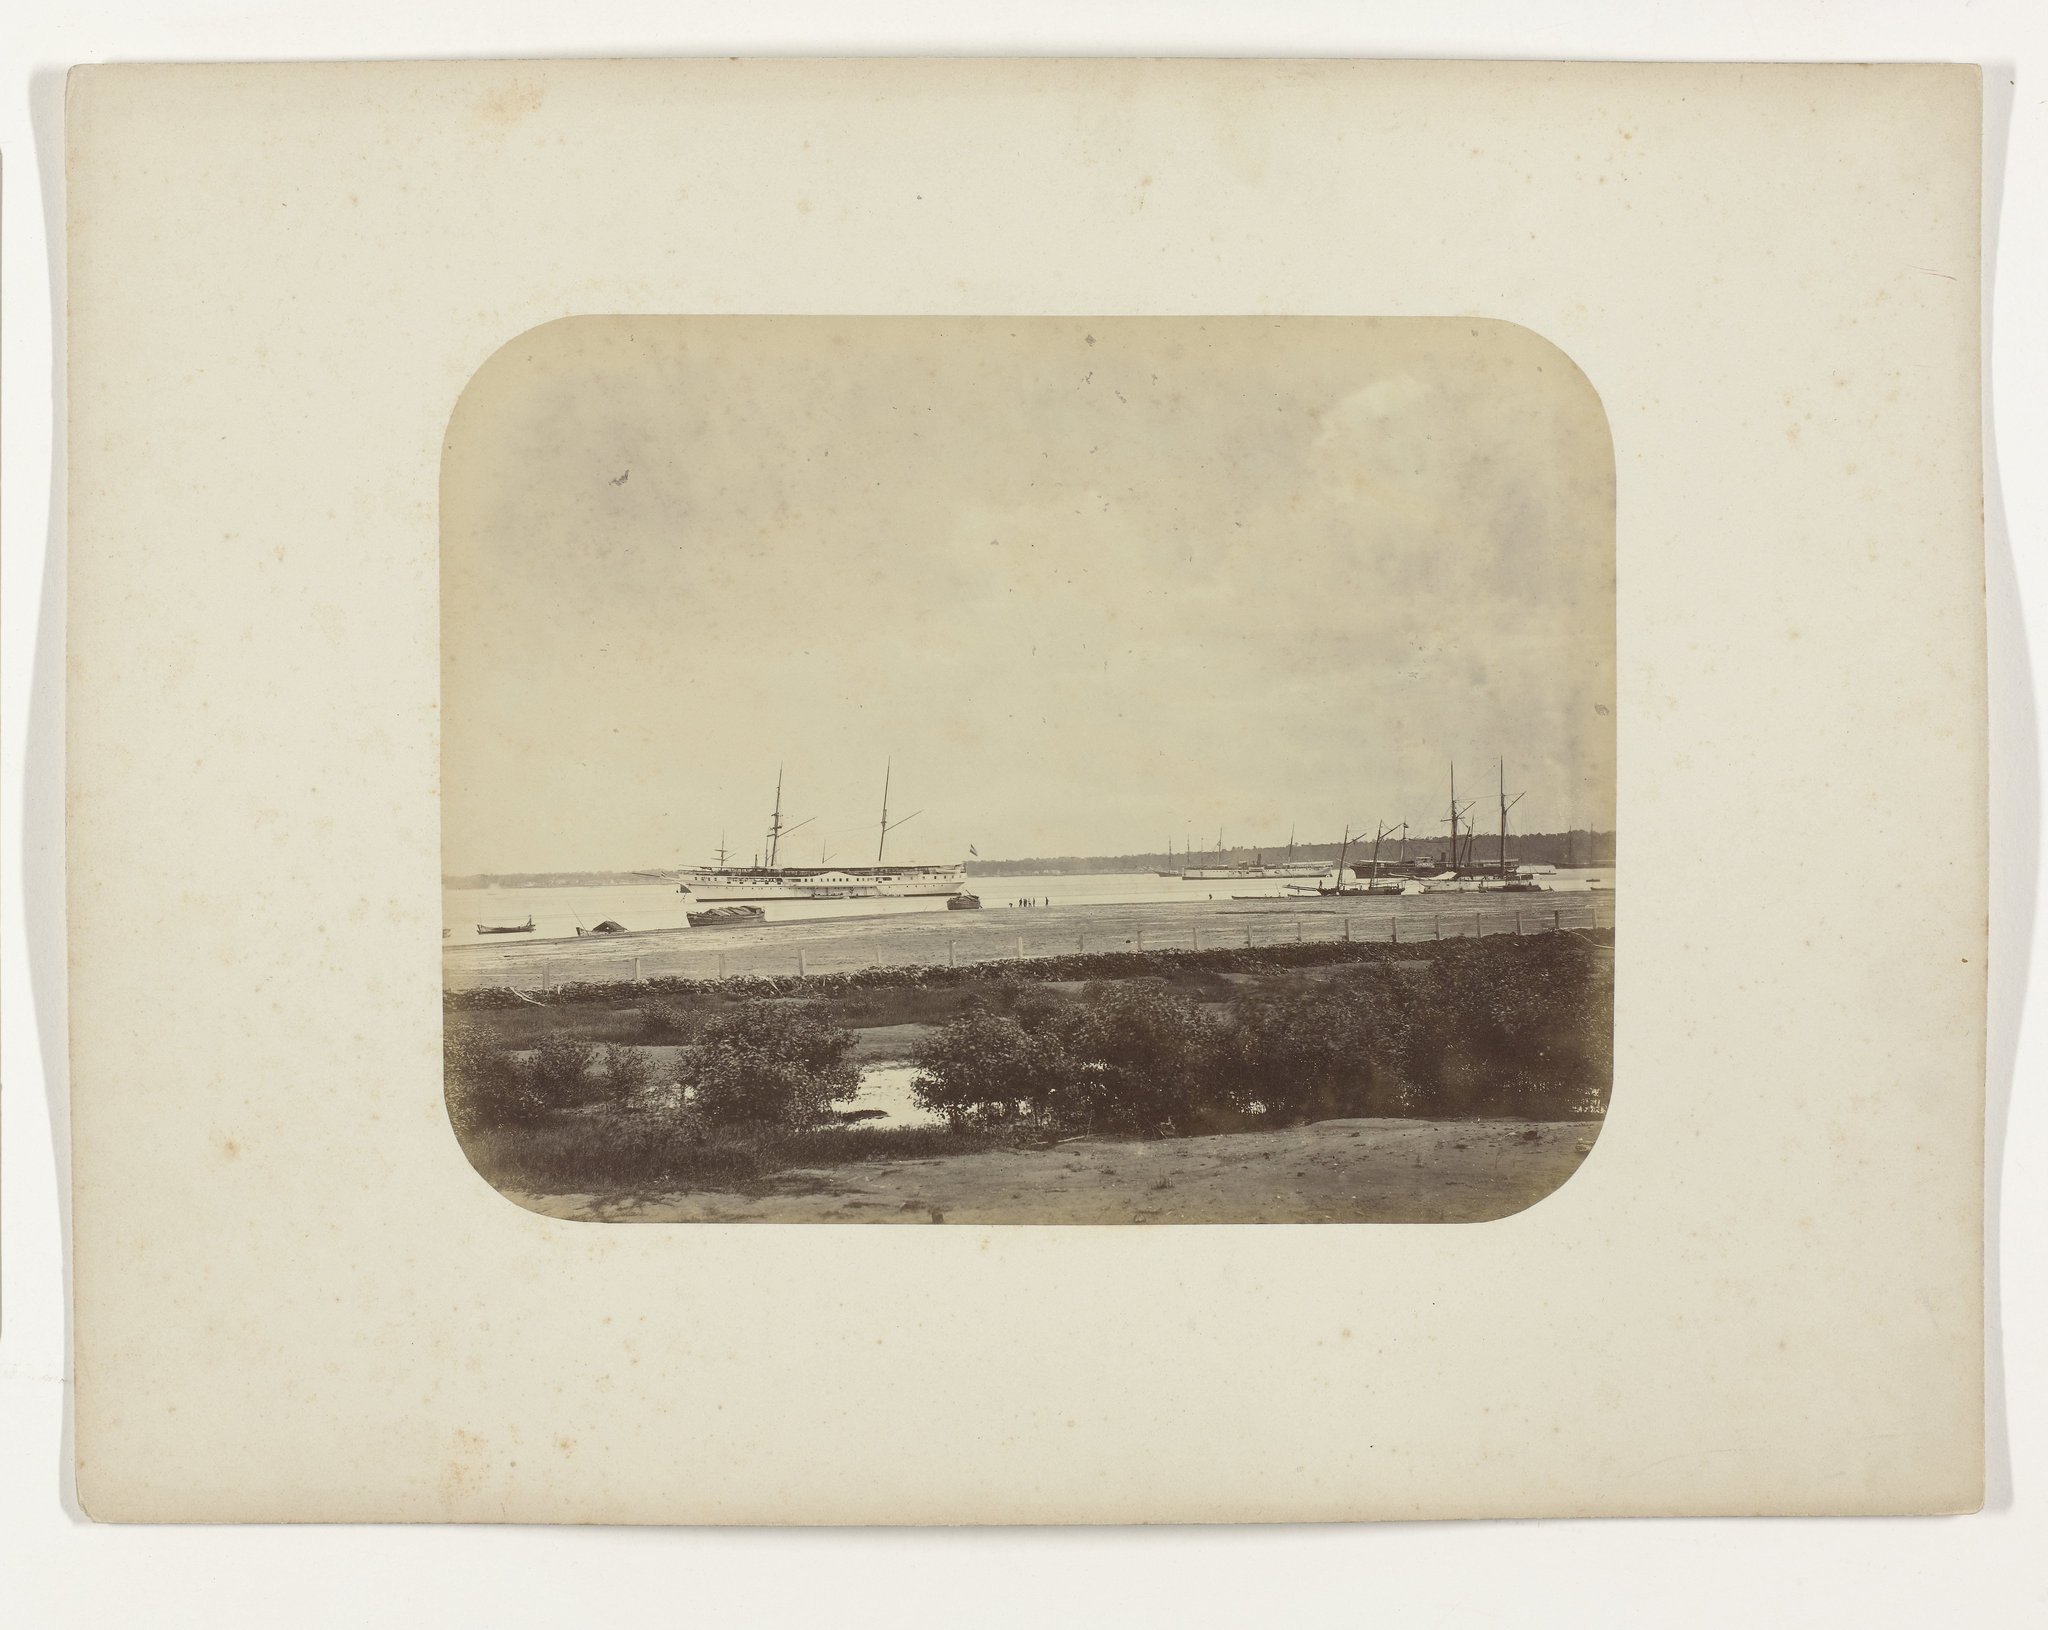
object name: photograph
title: De rede van Surabaya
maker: herman salzwedel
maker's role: fotograaf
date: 1876-1884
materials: photographic support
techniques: albumen print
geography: surabaya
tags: utrecht, the hague, colonial system, ship in the roads, roadstead, surabaya, java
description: De rede van Surabaya met centraal een stoomschip voor anker dat tevens zeilschip is. Aan de rechterzijde vier andere schepen voor anker. Aan de kant liggen enkele schepen afgemeerd. Op de voorgrond struiken en daarvoor een beschoeiing van palen en stenen. Onderdeel van het fotoalbum door de Soerabayasche Vereeniging van Suikerfabrikanten aangeboden aan Frederik Beyerinck, resident van Soerabaja.